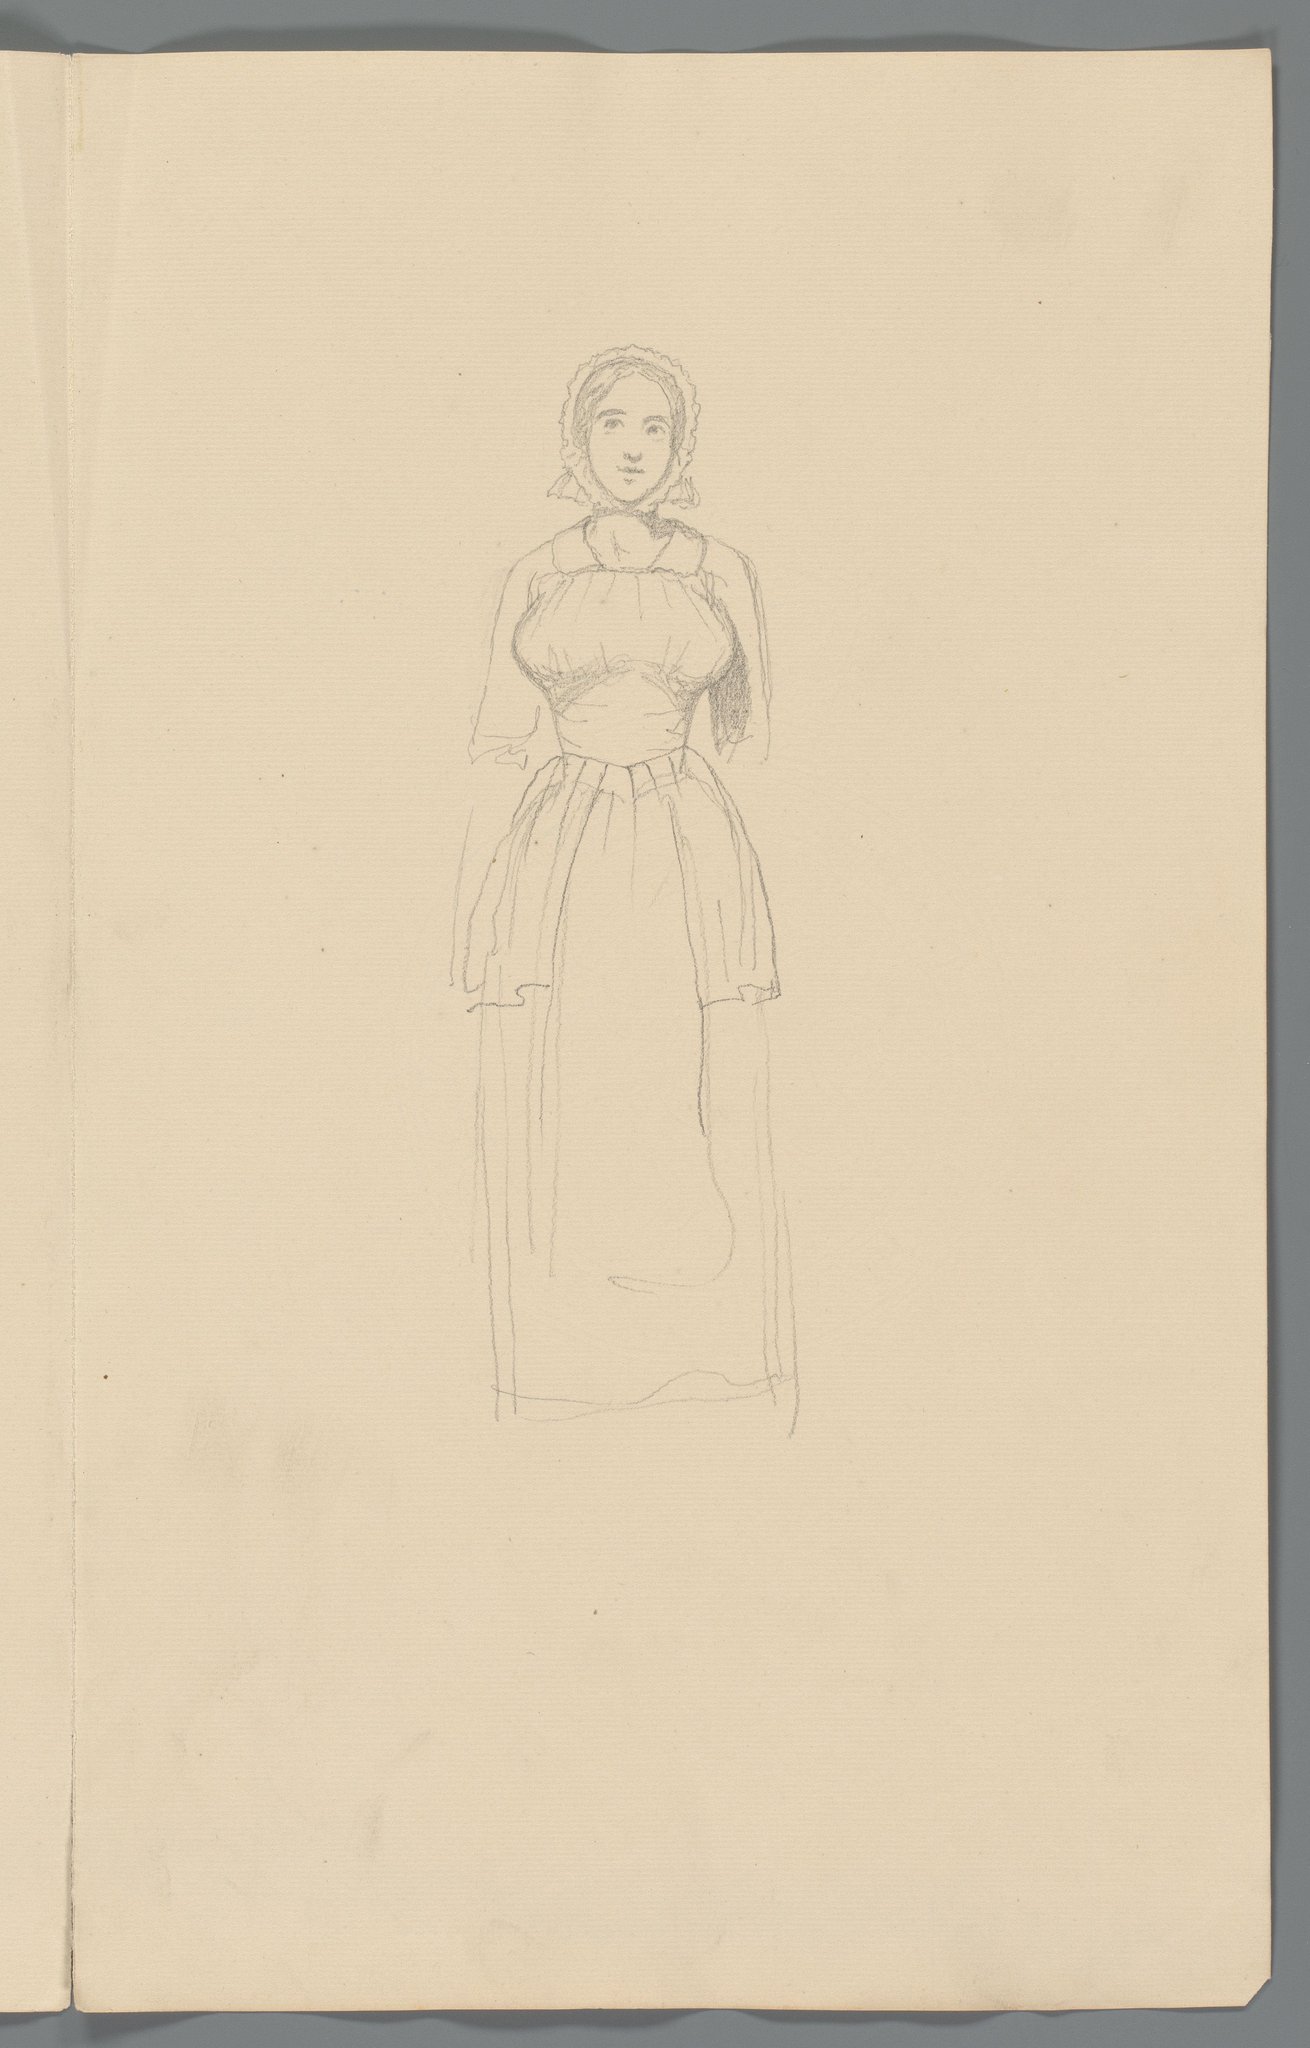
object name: drawing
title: Staande vrouw met schort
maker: jacobus everhardus josephus van den berg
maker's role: draughtsman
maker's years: 1802-1861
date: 1812-1861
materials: paper, pencil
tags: standing figure - aa - female human figure